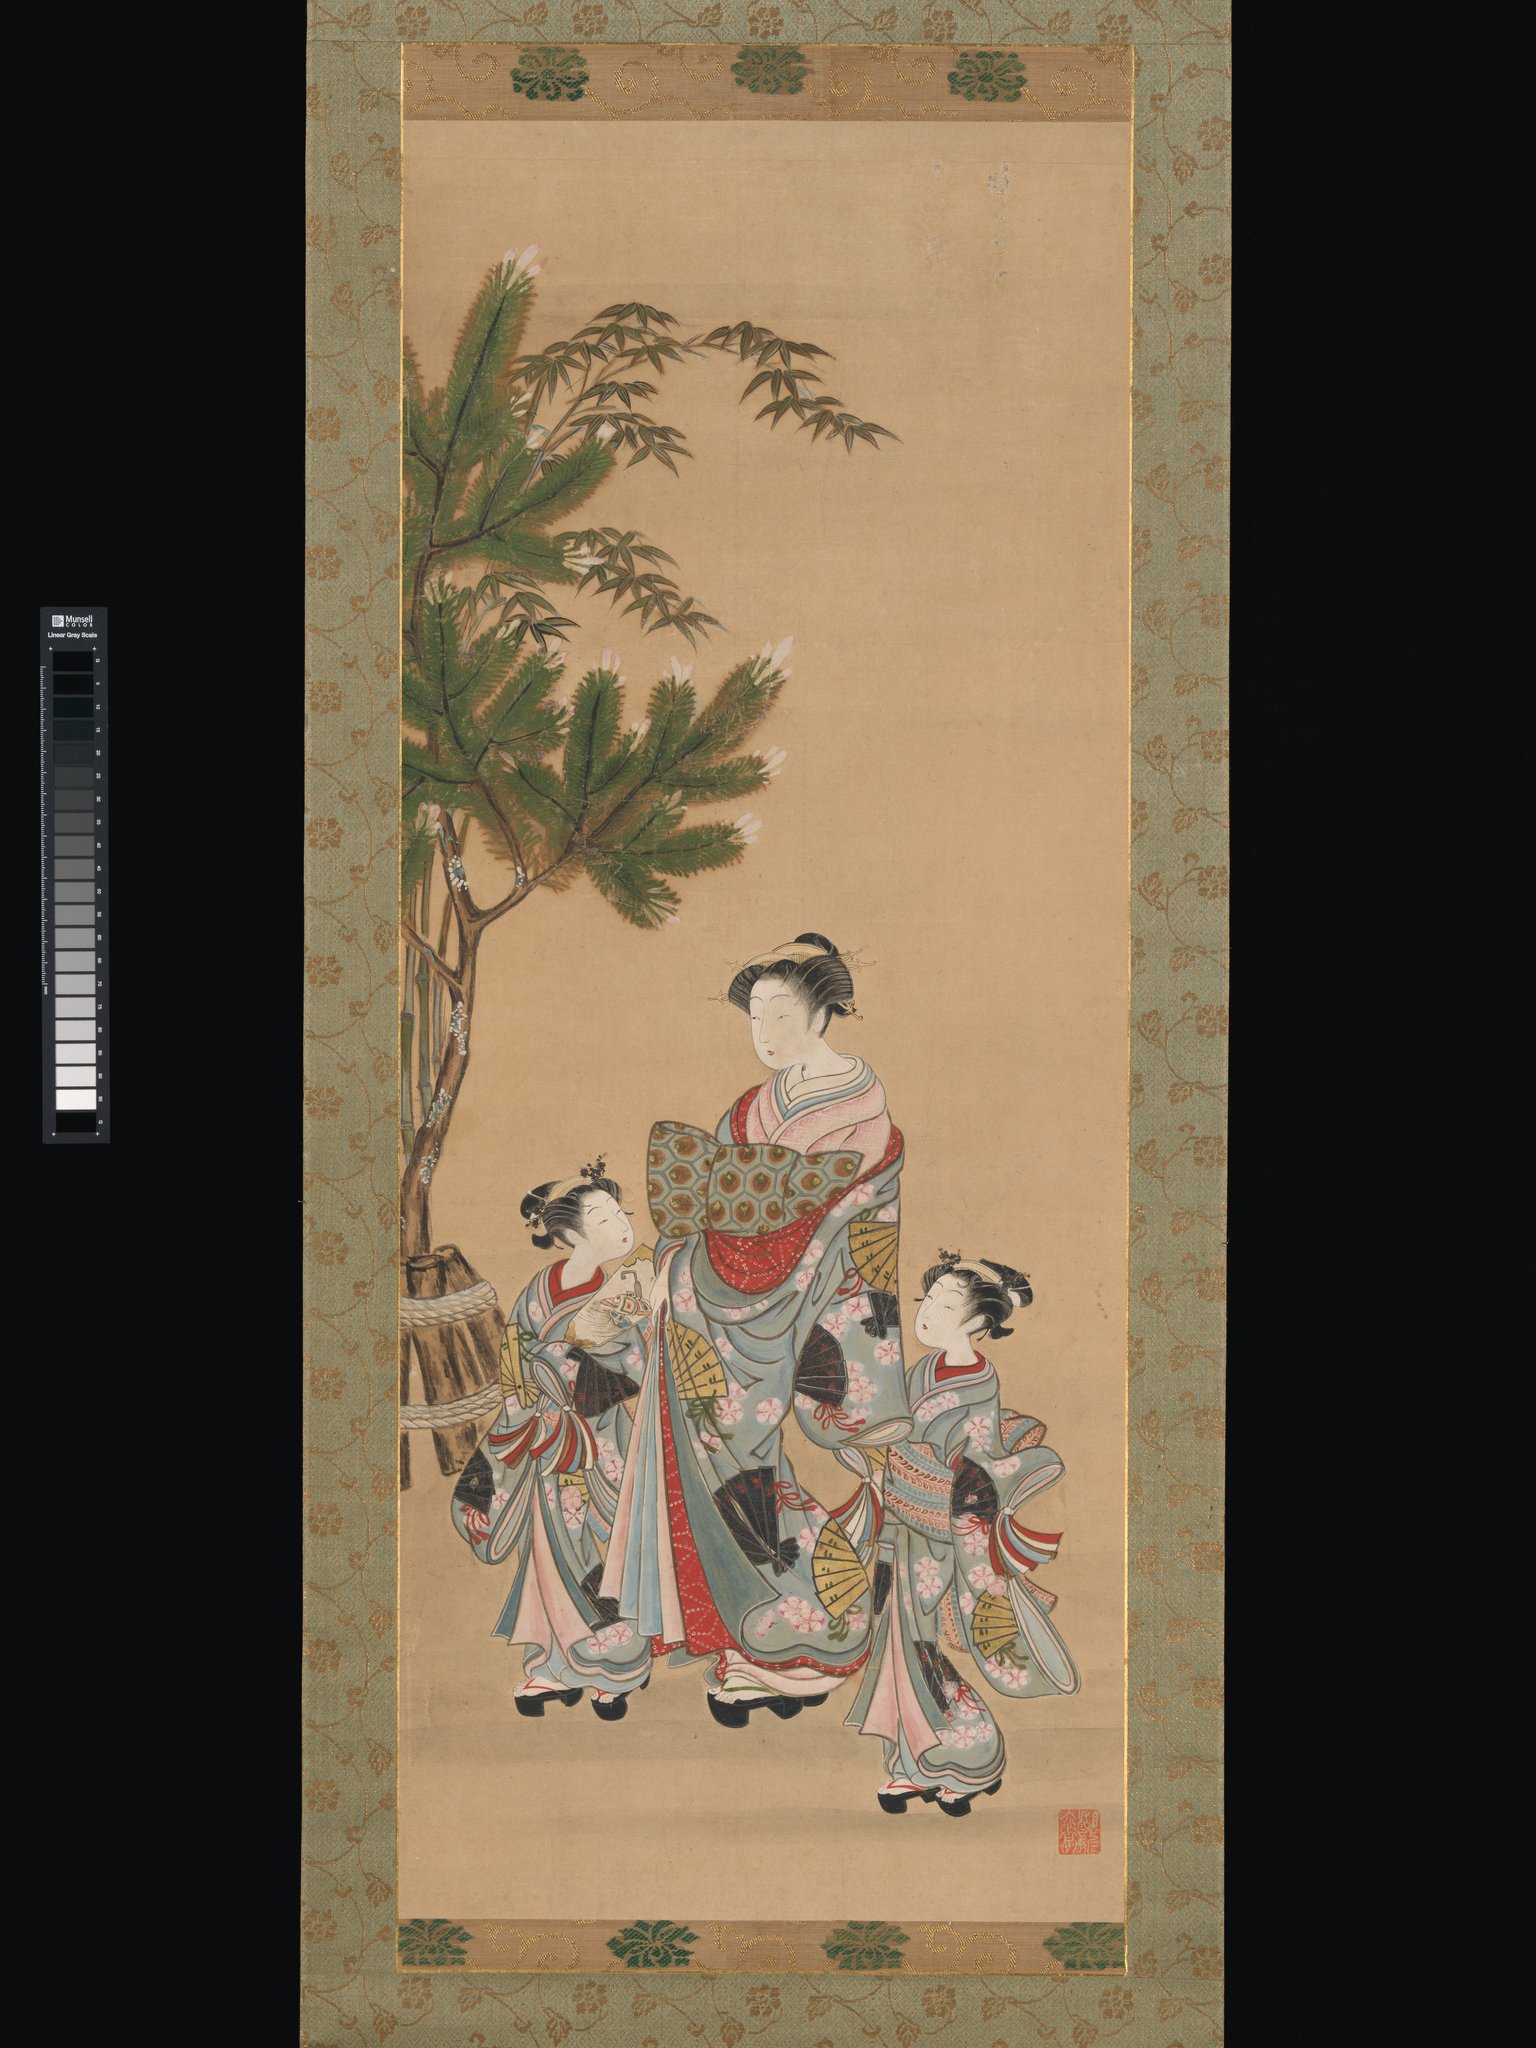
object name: hanging scroll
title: Courtesan and Two Attendants on New Year's Day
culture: japanese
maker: isoda koryūsai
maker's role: artist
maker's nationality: japanese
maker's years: 1735-1790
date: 1780-1789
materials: gold, ink, paper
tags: girls,women